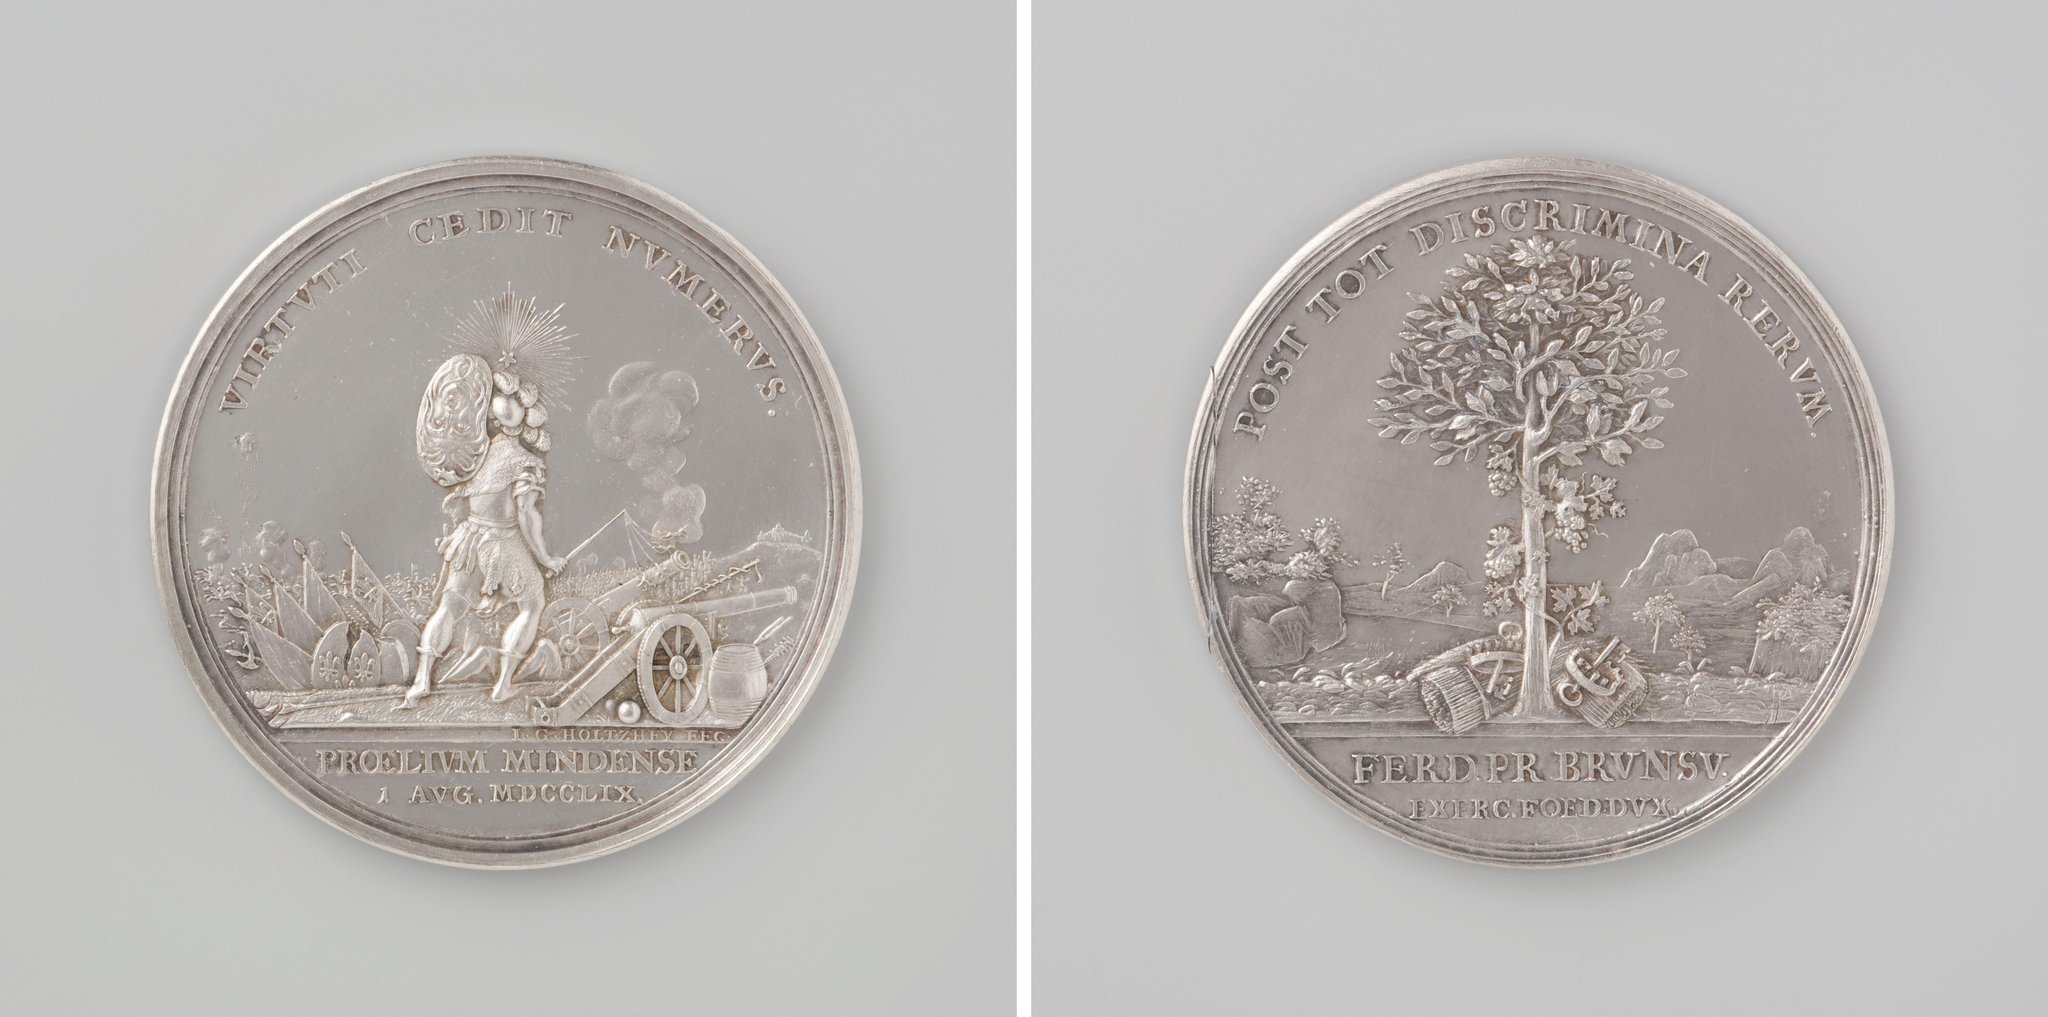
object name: history medal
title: Overwinning van Ferdinand van Brunswijk-Wolfenbuttel op de Fransen bij Minden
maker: johan george holtzhey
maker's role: mintmaster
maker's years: 1726-1808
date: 1759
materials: silver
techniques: striking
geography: amsterdam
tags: wolfenbüttel, braunschweig, militair, hertog, veldheer, ferdinand hertog van brunswijk-wolfenbüttel, minden, slag bij minden